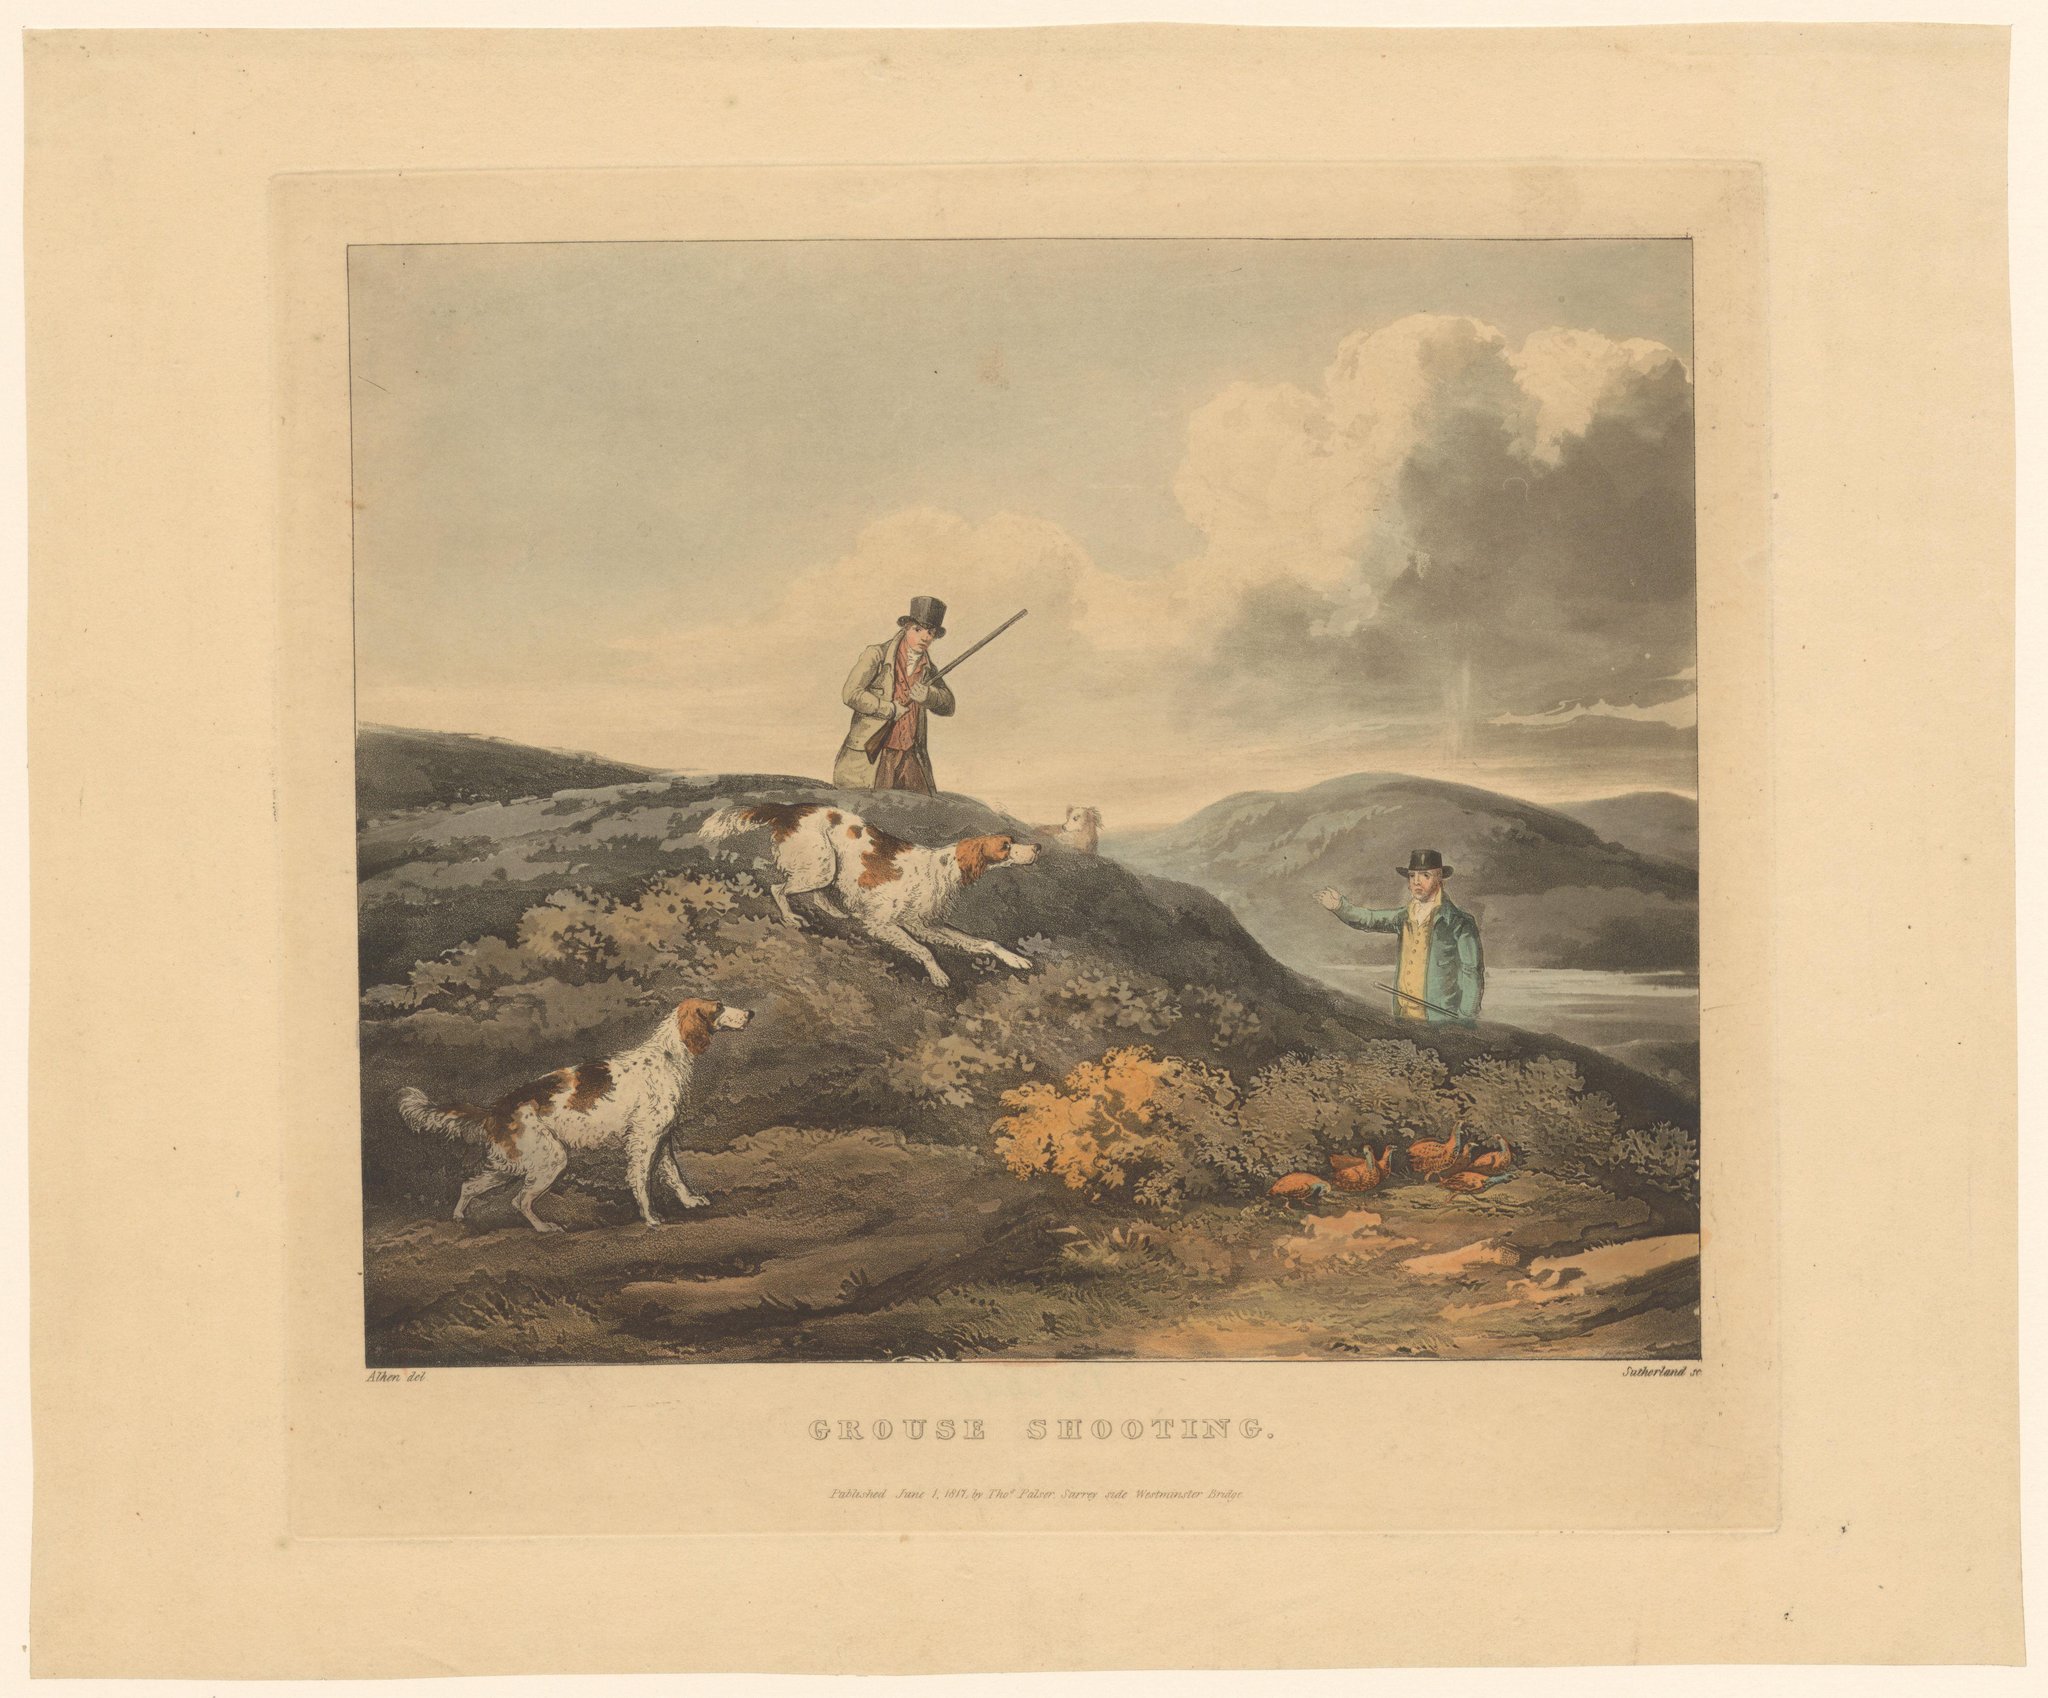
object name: print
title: Twee jagers en drie honden op hoenderjacht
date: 1806-1817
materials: paper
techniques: etching, hand coloring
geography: london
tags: walker and runner birds, bird hunting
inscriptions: collector's mark: Lugt 2233